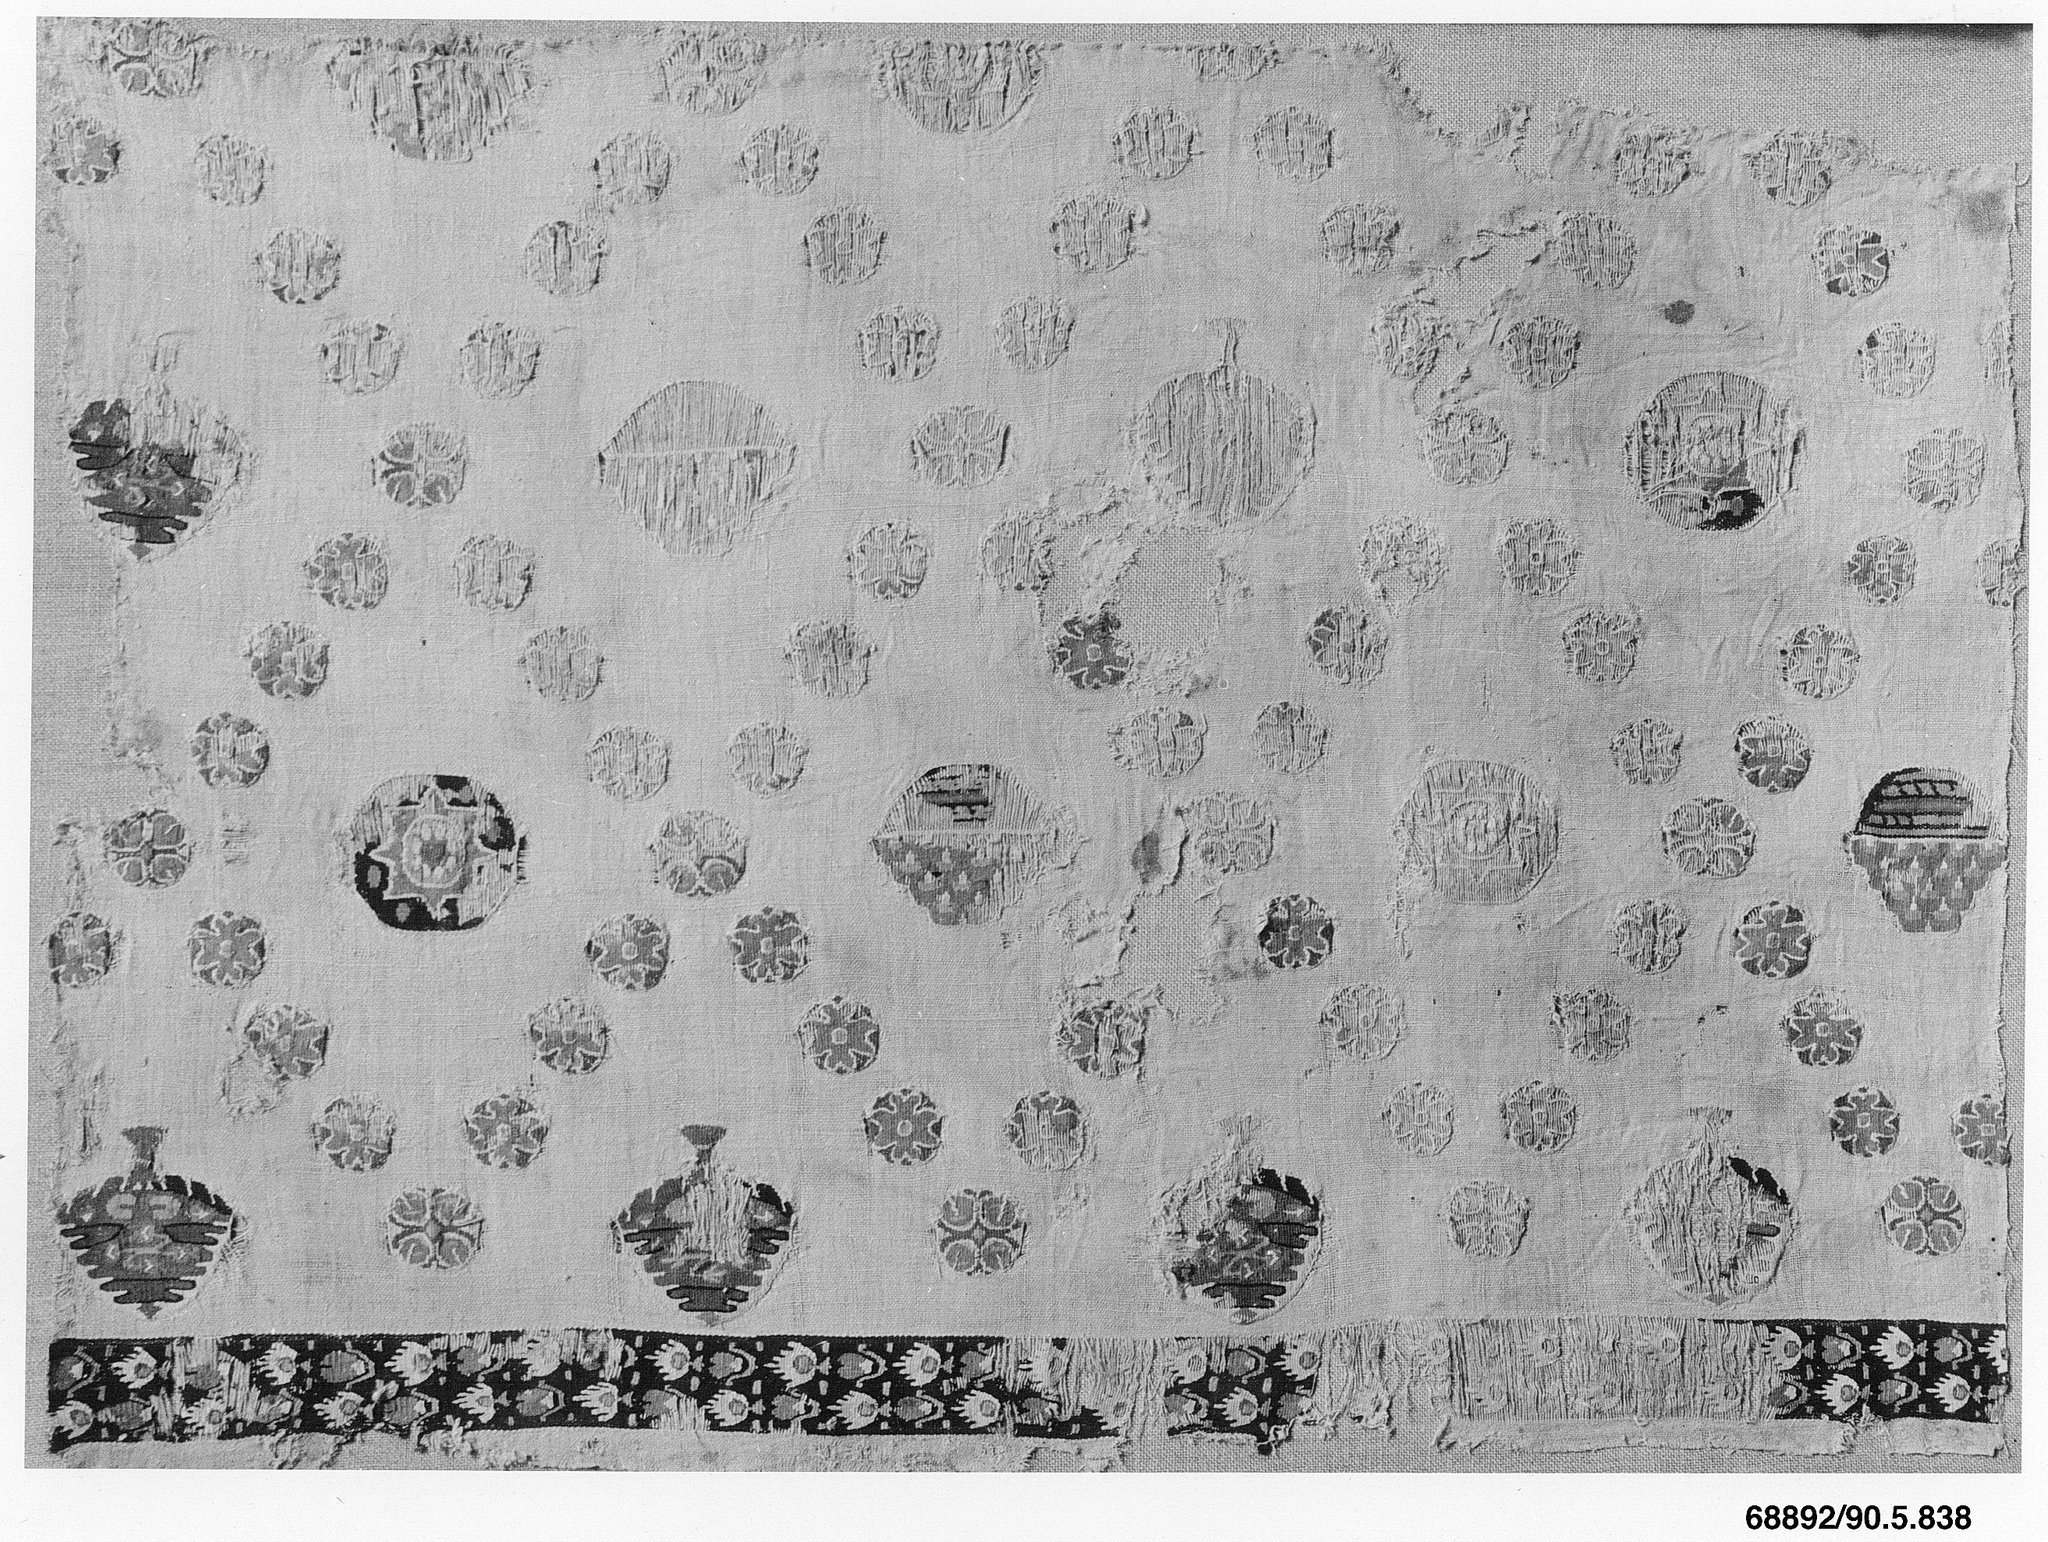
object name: textile fragment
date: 401-600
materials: linen, wool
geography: egypt